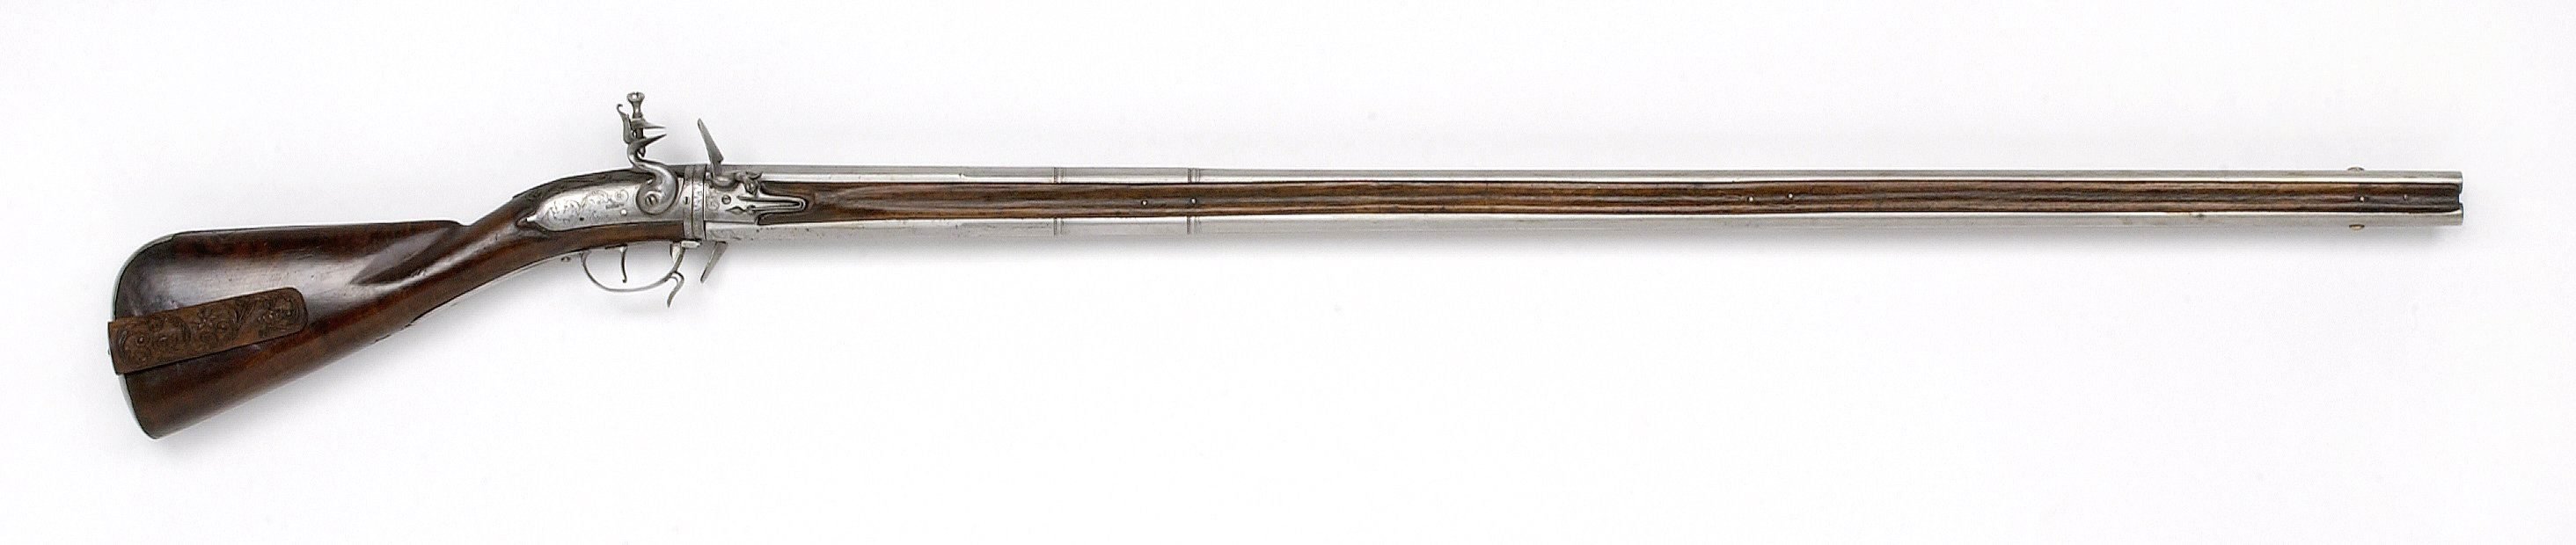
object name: superposee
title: Dubbelloops vuursteendraailoopgeweer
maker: Anonymous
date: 1670-1680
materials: horn, iron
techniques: printing, cutting, engraving, filing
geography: maastricht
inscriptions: inscription: ‘MASTRECK’, mark: ‘28’, mark: ‘M // D’